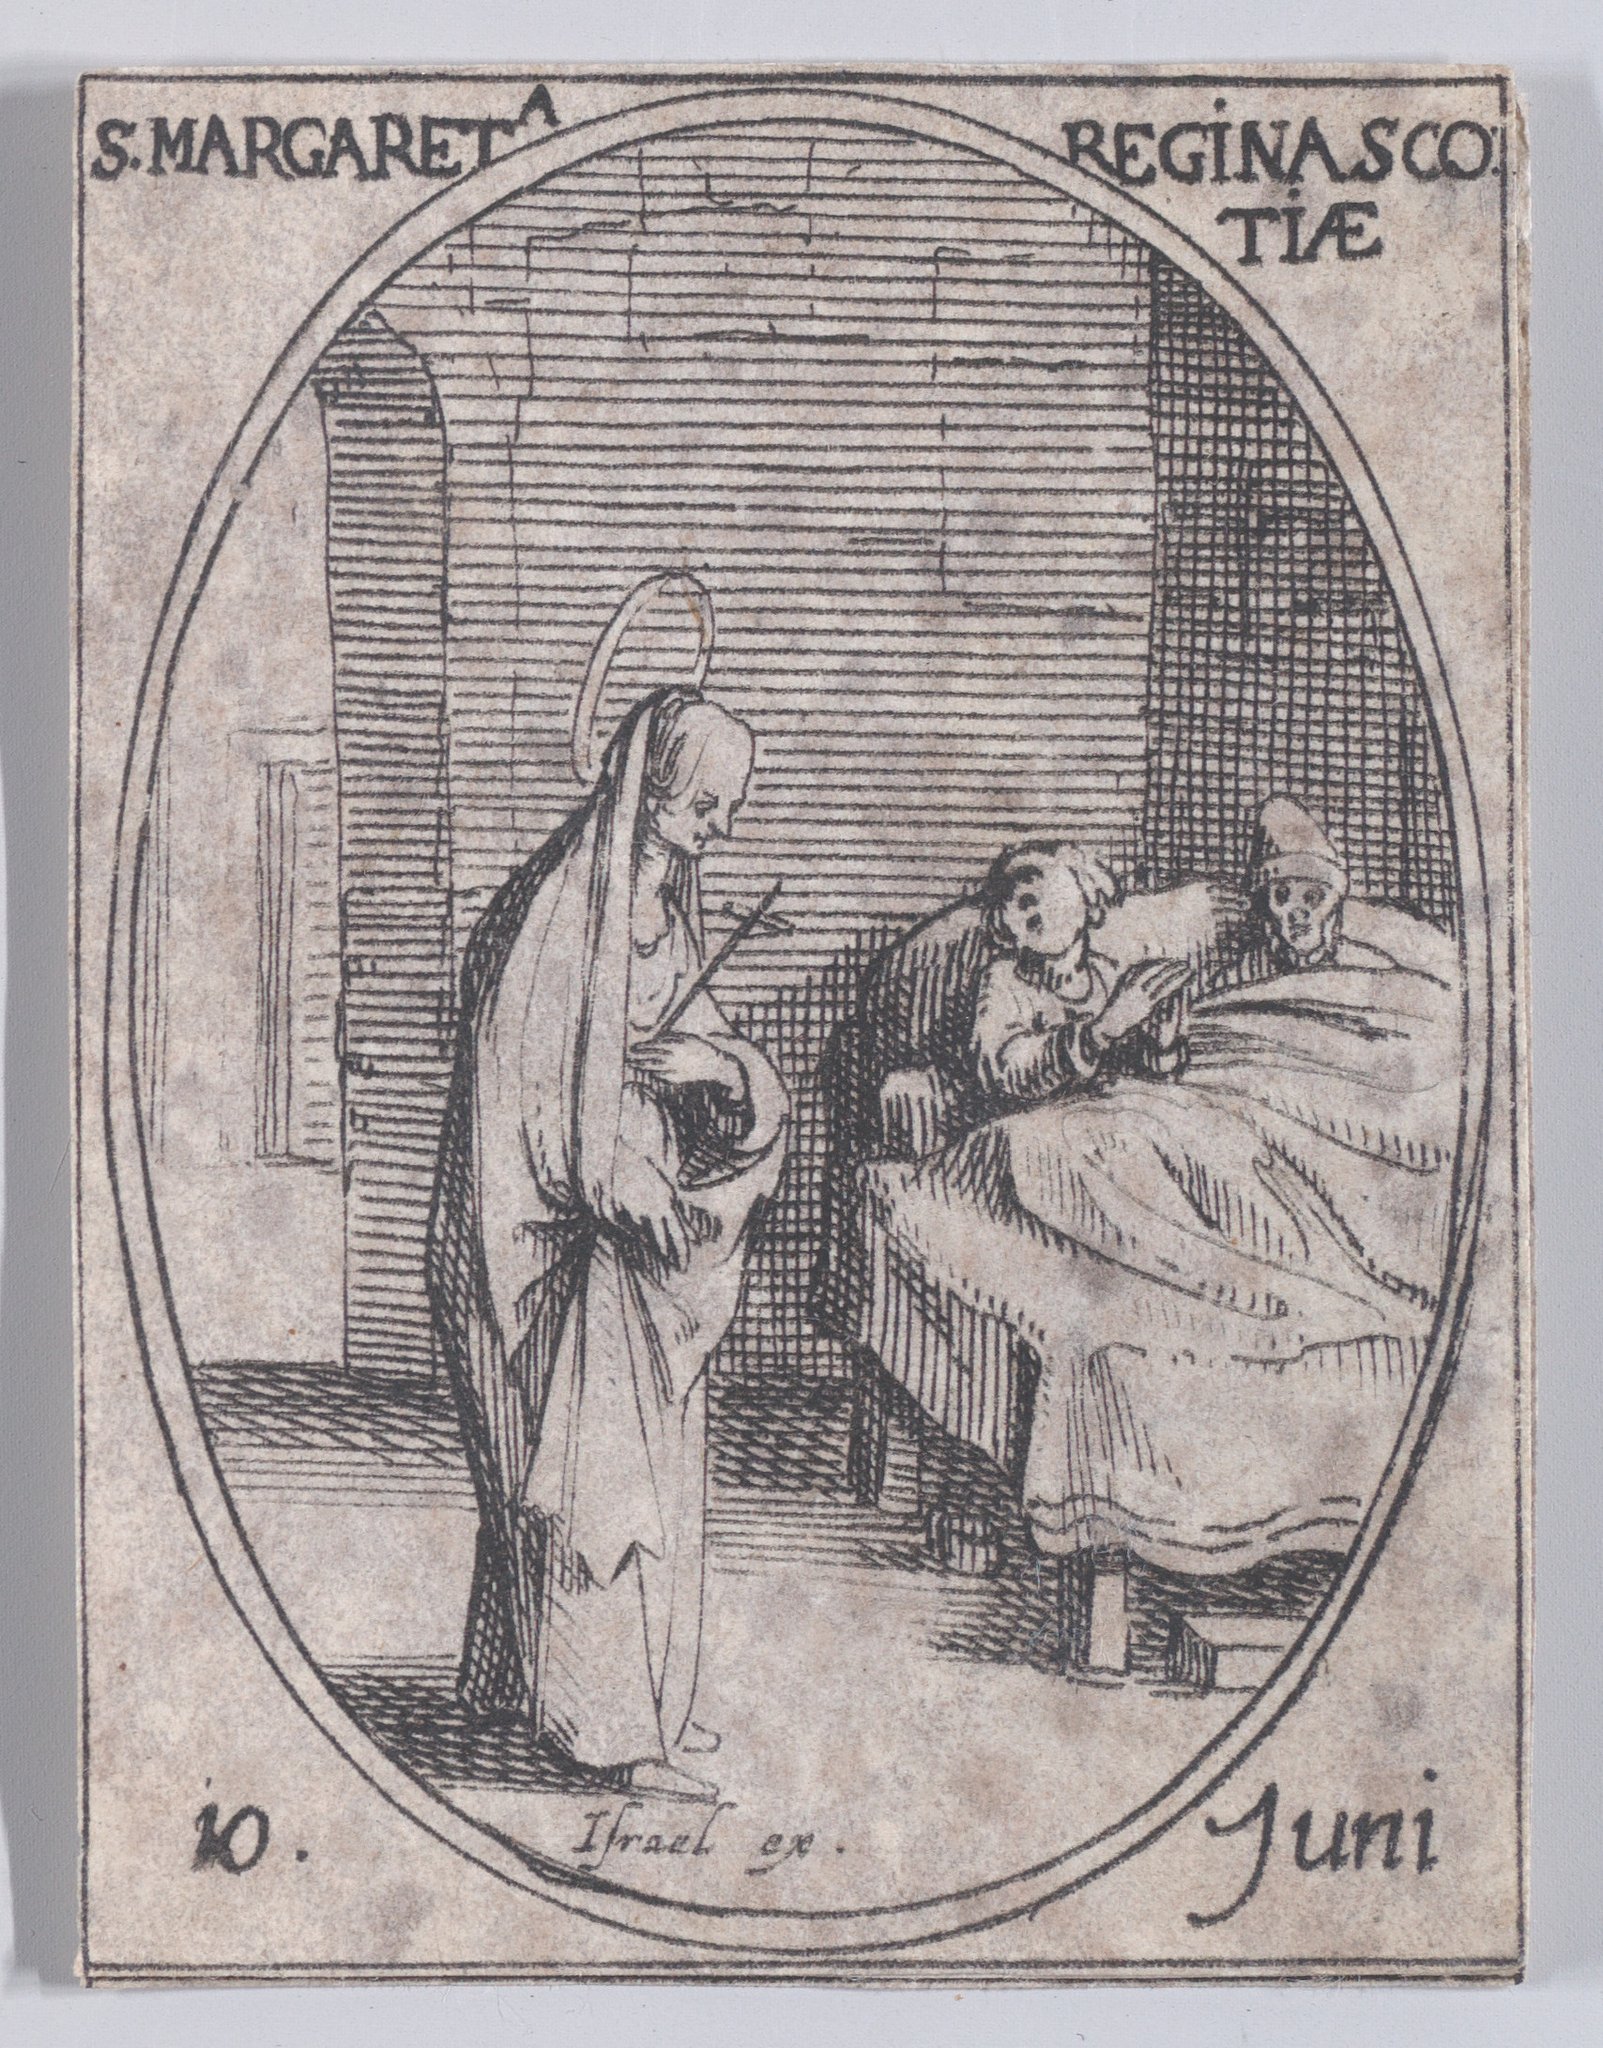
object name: print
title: Ste. Marguerite, Reine de Écosse (St. Margaret, Queen of Scotland), June 10th, from "Les Images De Tous Les Saincts et Saintes de L'Année" (Images of All of the Saints and Religious Events of the Year)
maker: jacques callot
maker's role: artist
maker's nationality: french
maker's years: 1592-1635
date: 1636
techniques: etching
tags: women,saints,beds